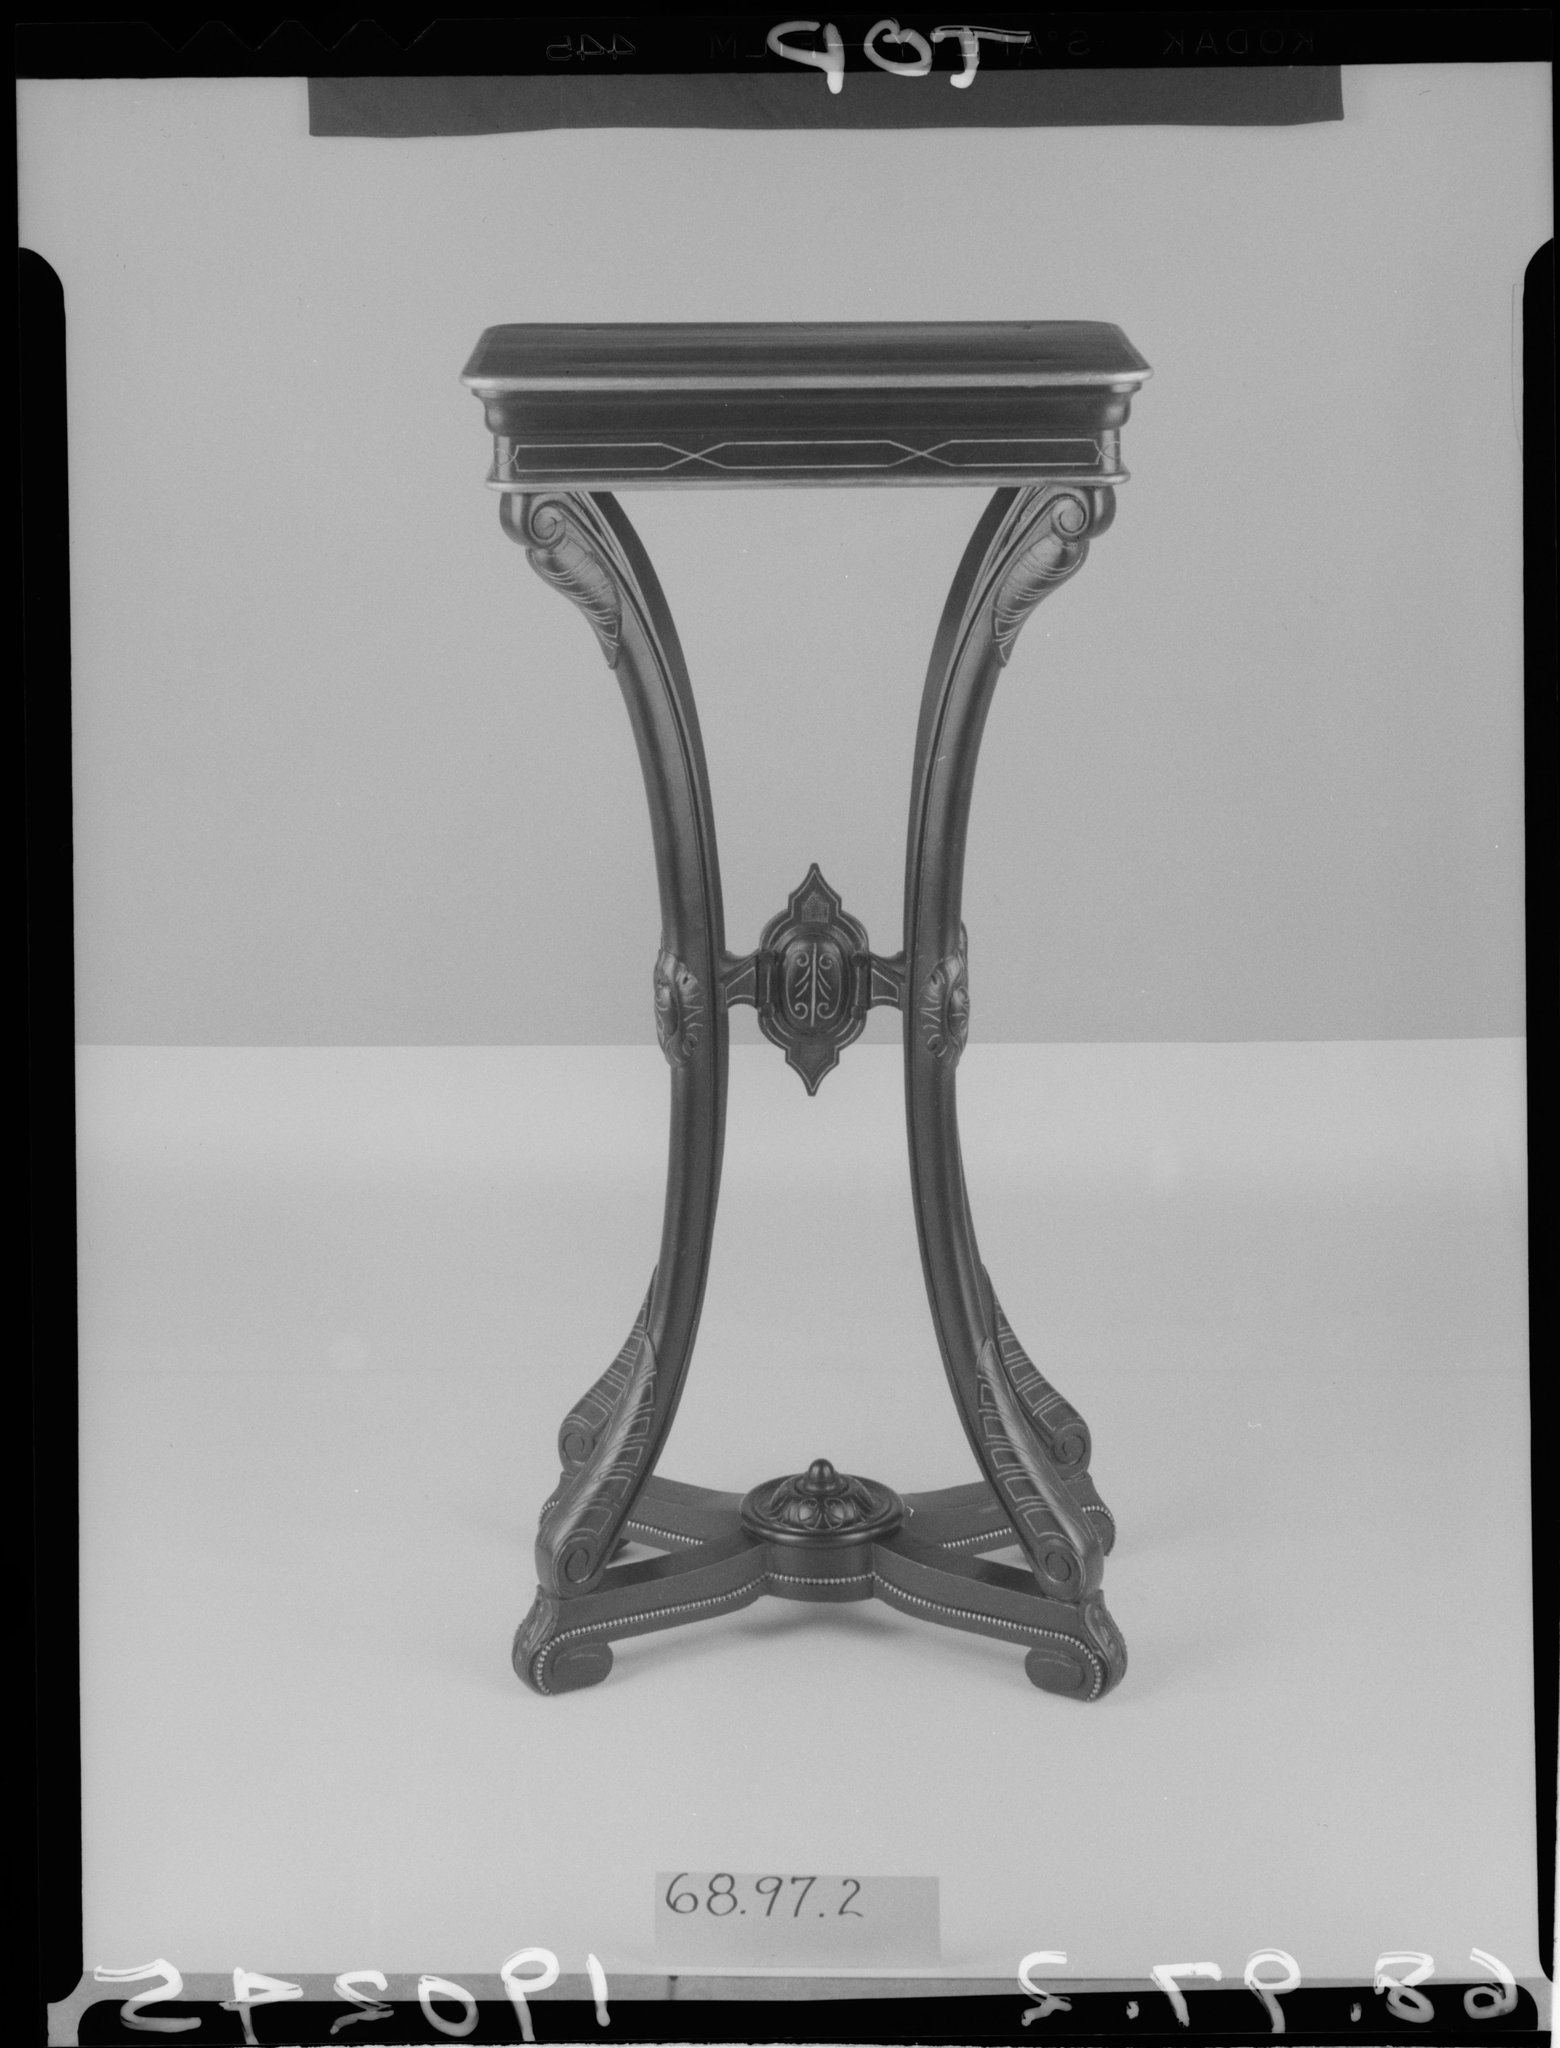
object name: pedestal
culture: american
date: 1870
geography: united states